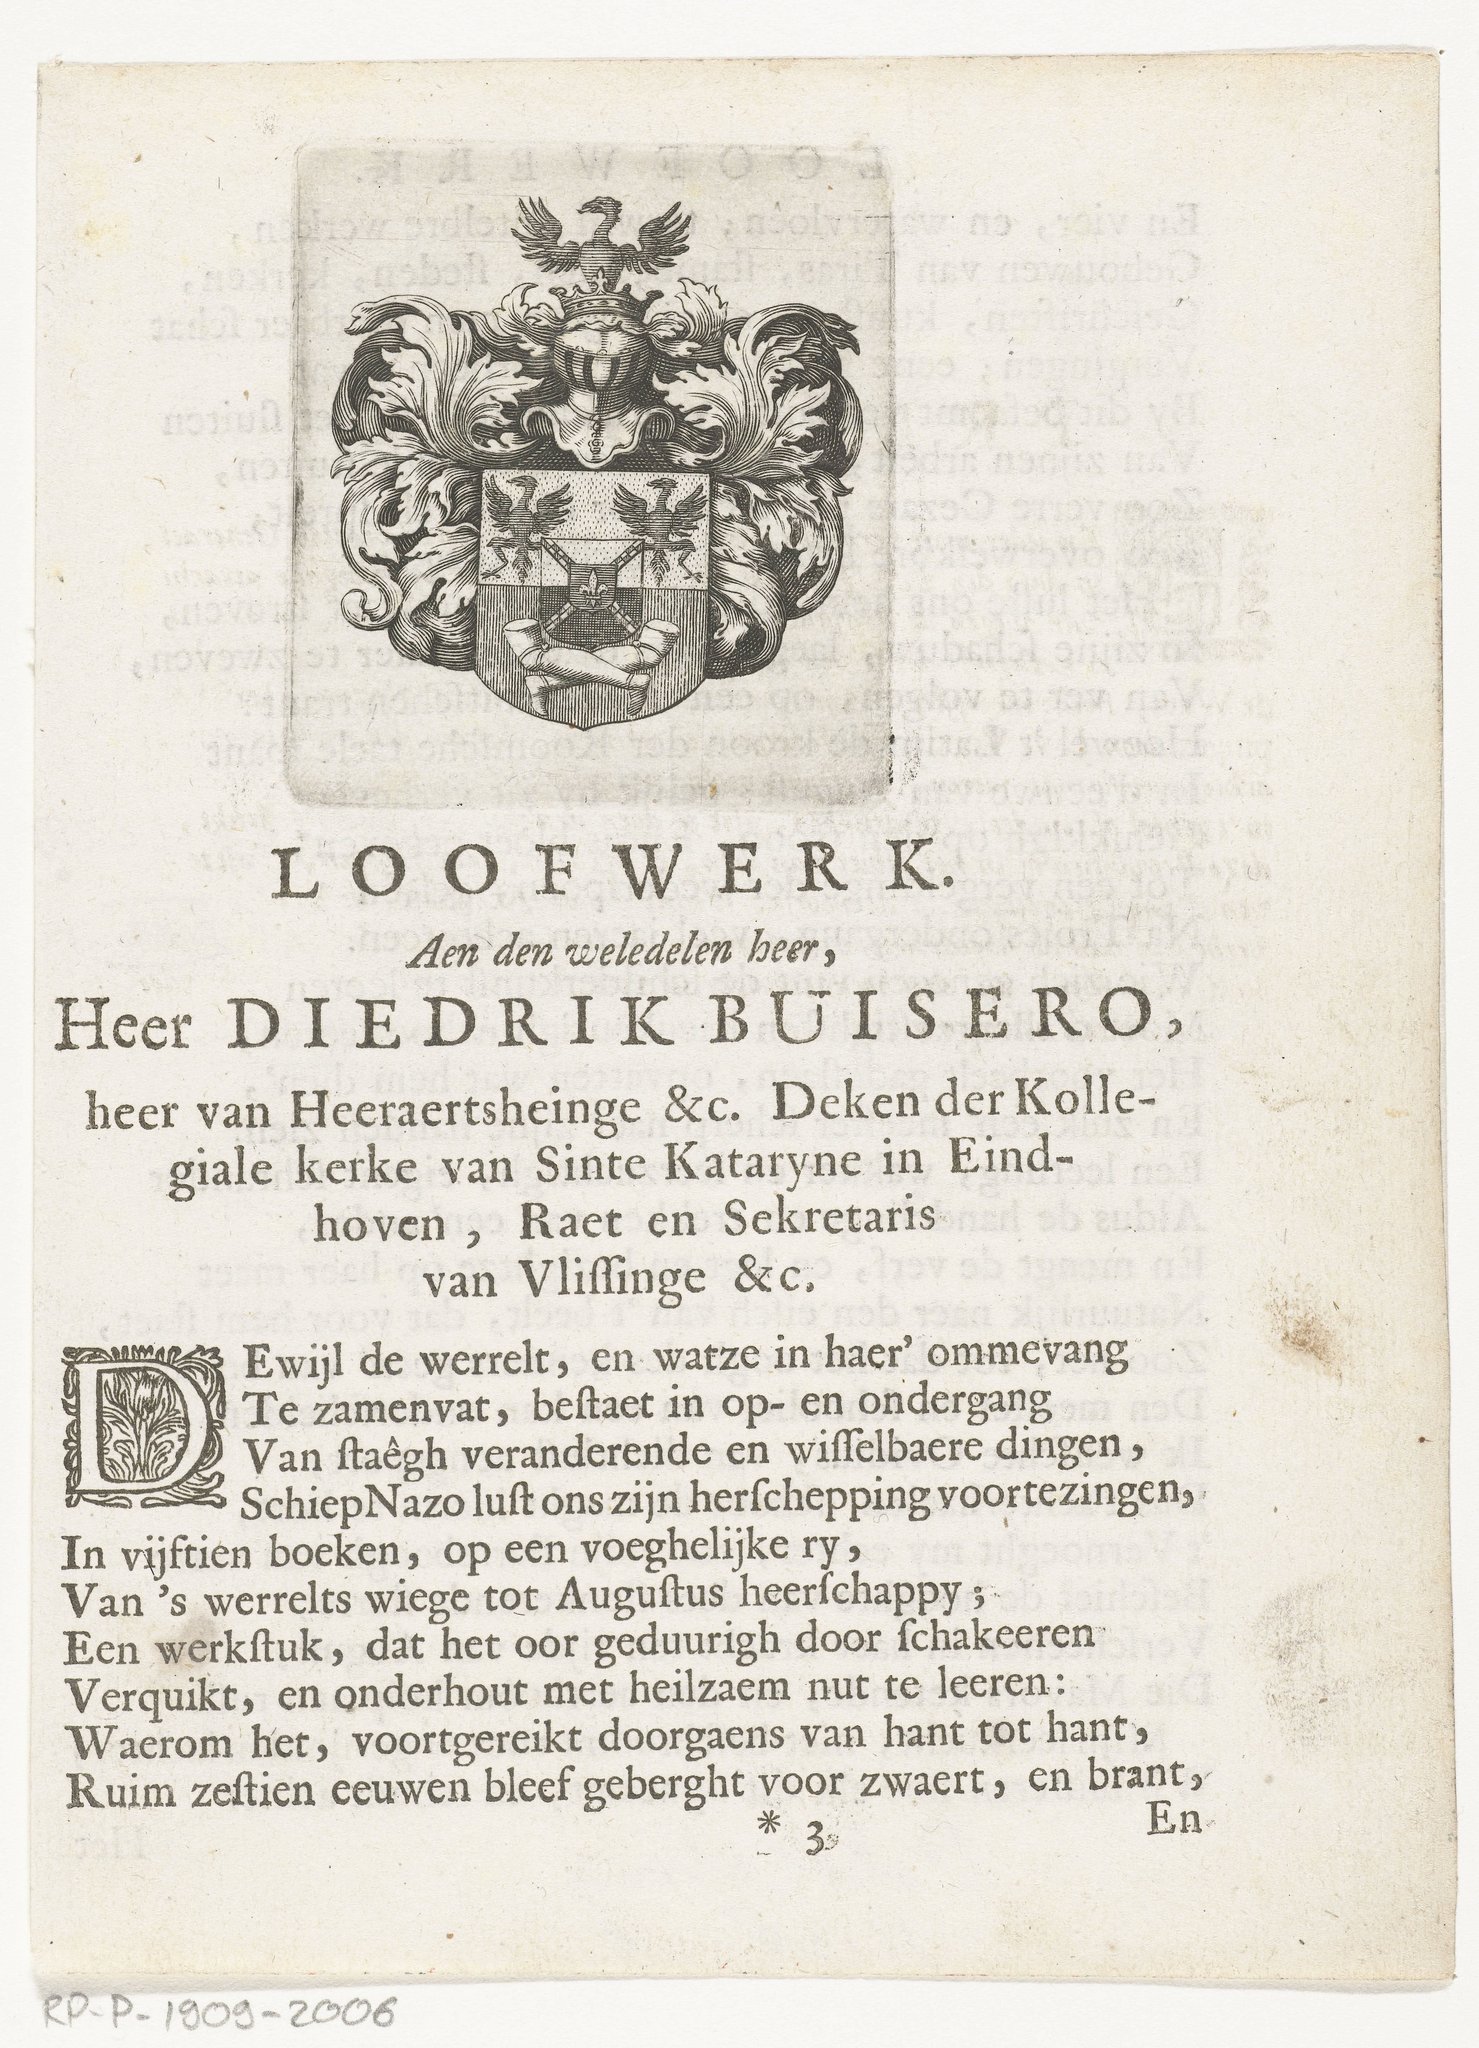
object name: print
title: Herscheppinge Publius Ovidius Naso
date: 1671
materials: paper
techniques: engraving, letterpress printing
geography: amsterdam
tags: the hague, rotterdam, dirk buysero, armorial bearing, heraldry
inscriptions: collector's mark: Lugt 2228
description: Illustratie uit: Publius Ovidius Naso, Herscheppinge (vertaling J. van Vondel), Amsterdam, voor de wed. A. de Wees (gedrukt bij D. Bakkamude), 1671.